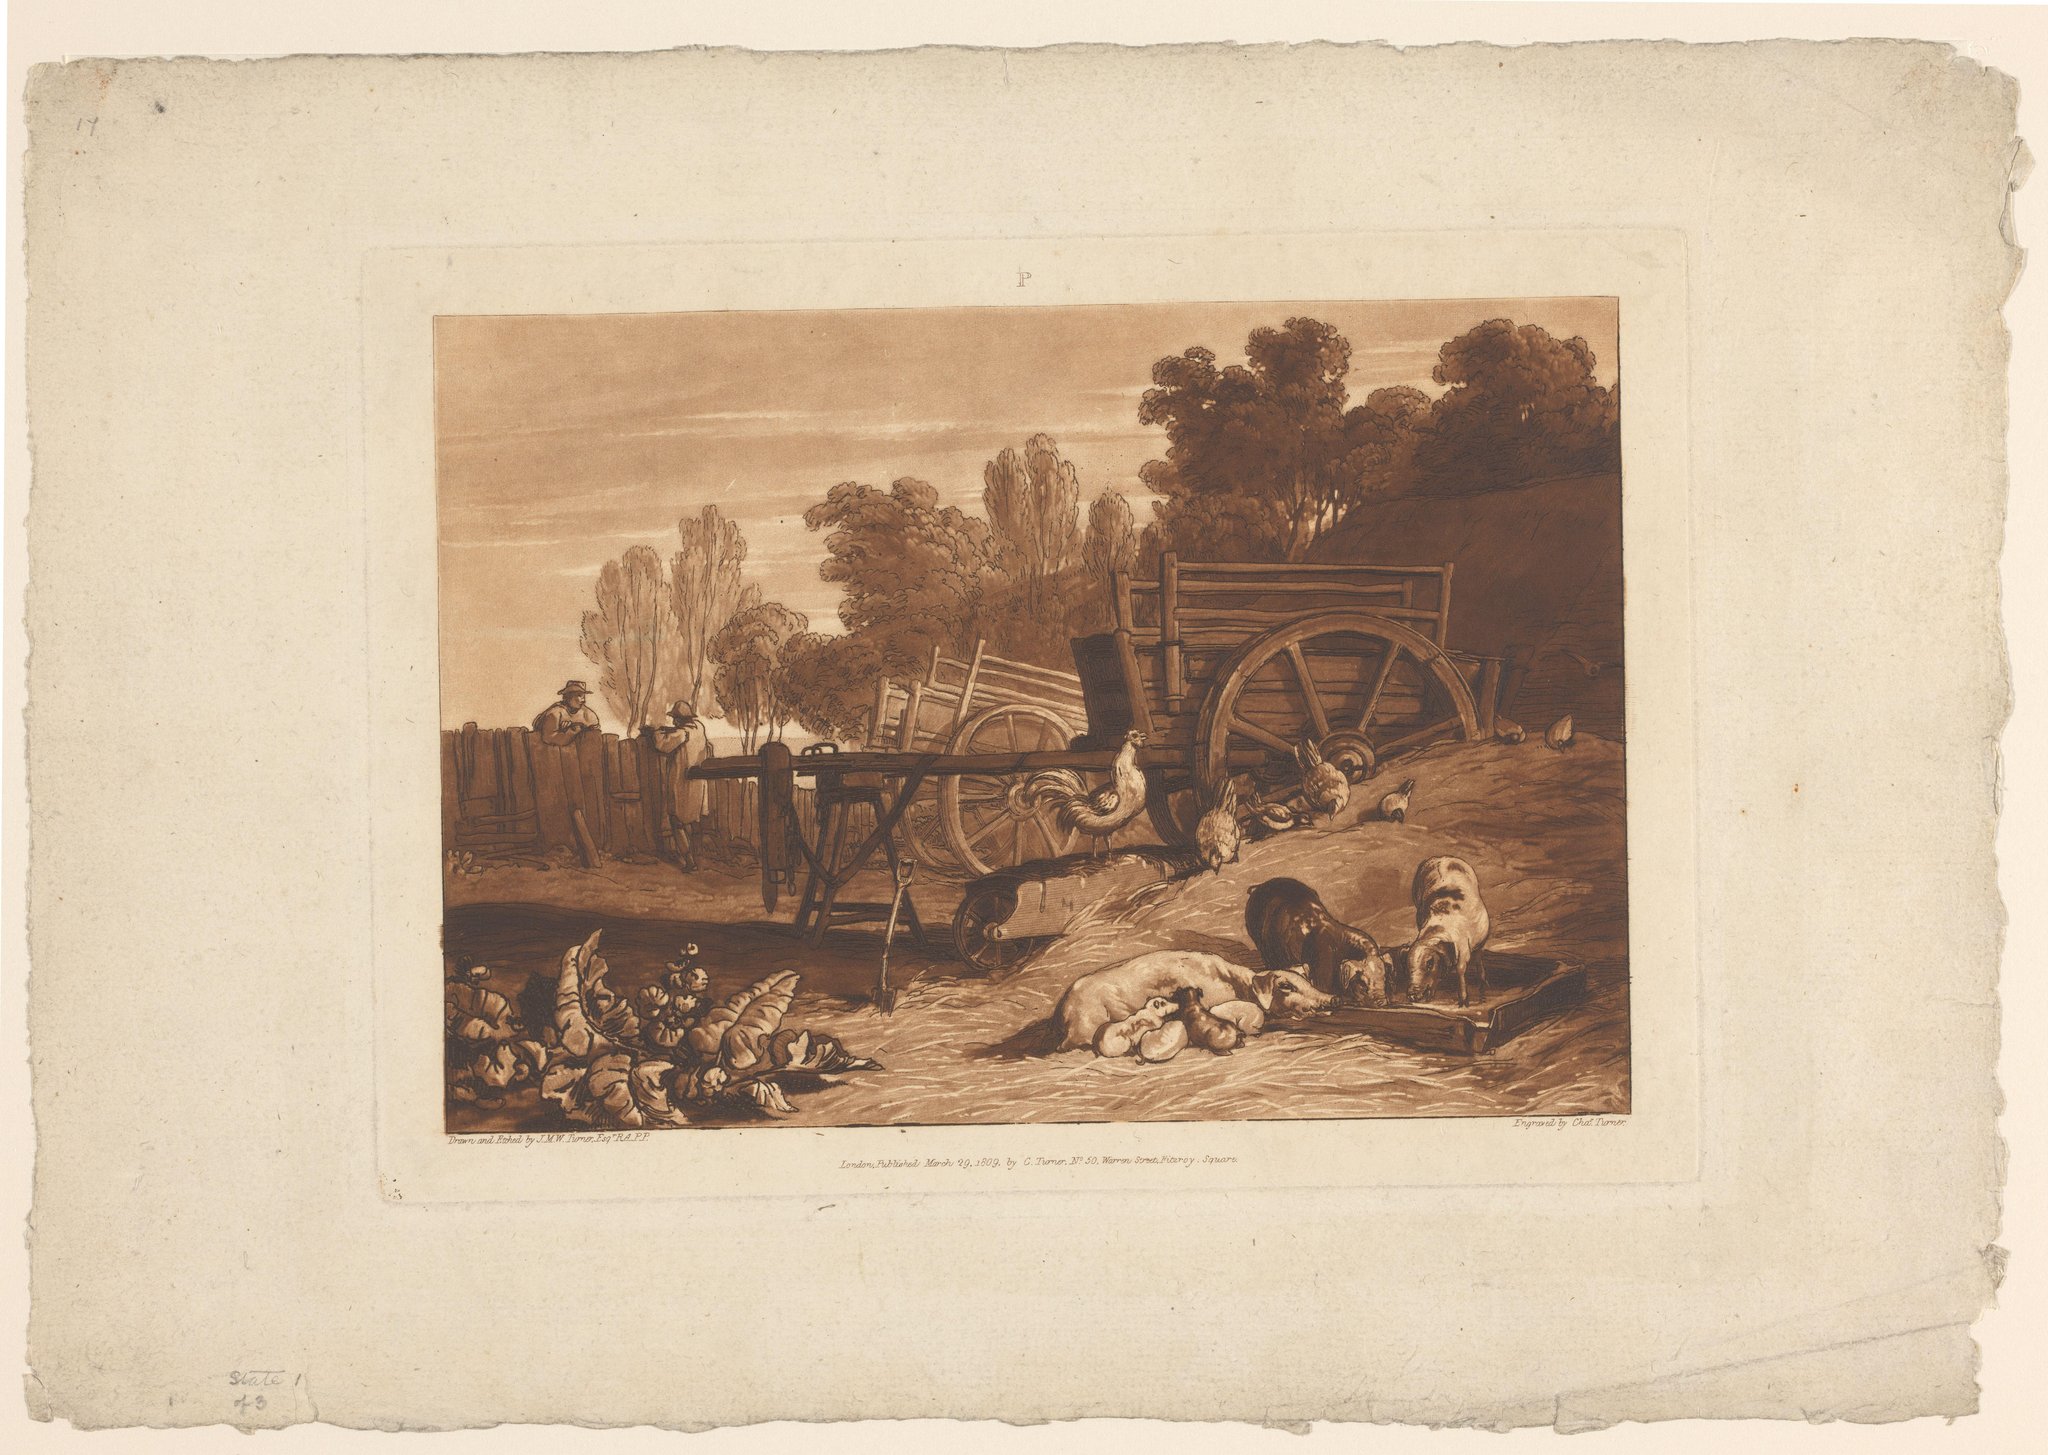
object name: print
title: Landschapsstudies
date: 1803-1809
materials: paper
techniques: etching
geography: london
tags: pig, piglet, suckling pig, fowl (cock, hen, chicken, etc.), (farm) wagon, freight wagon, cart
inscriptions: collector's mark: Lugt 2760, collector's mark: Lugt 2228